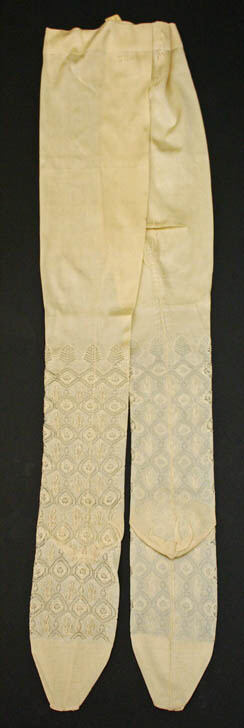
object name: stocking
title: Stockings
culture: french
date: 1880-1889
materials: silk